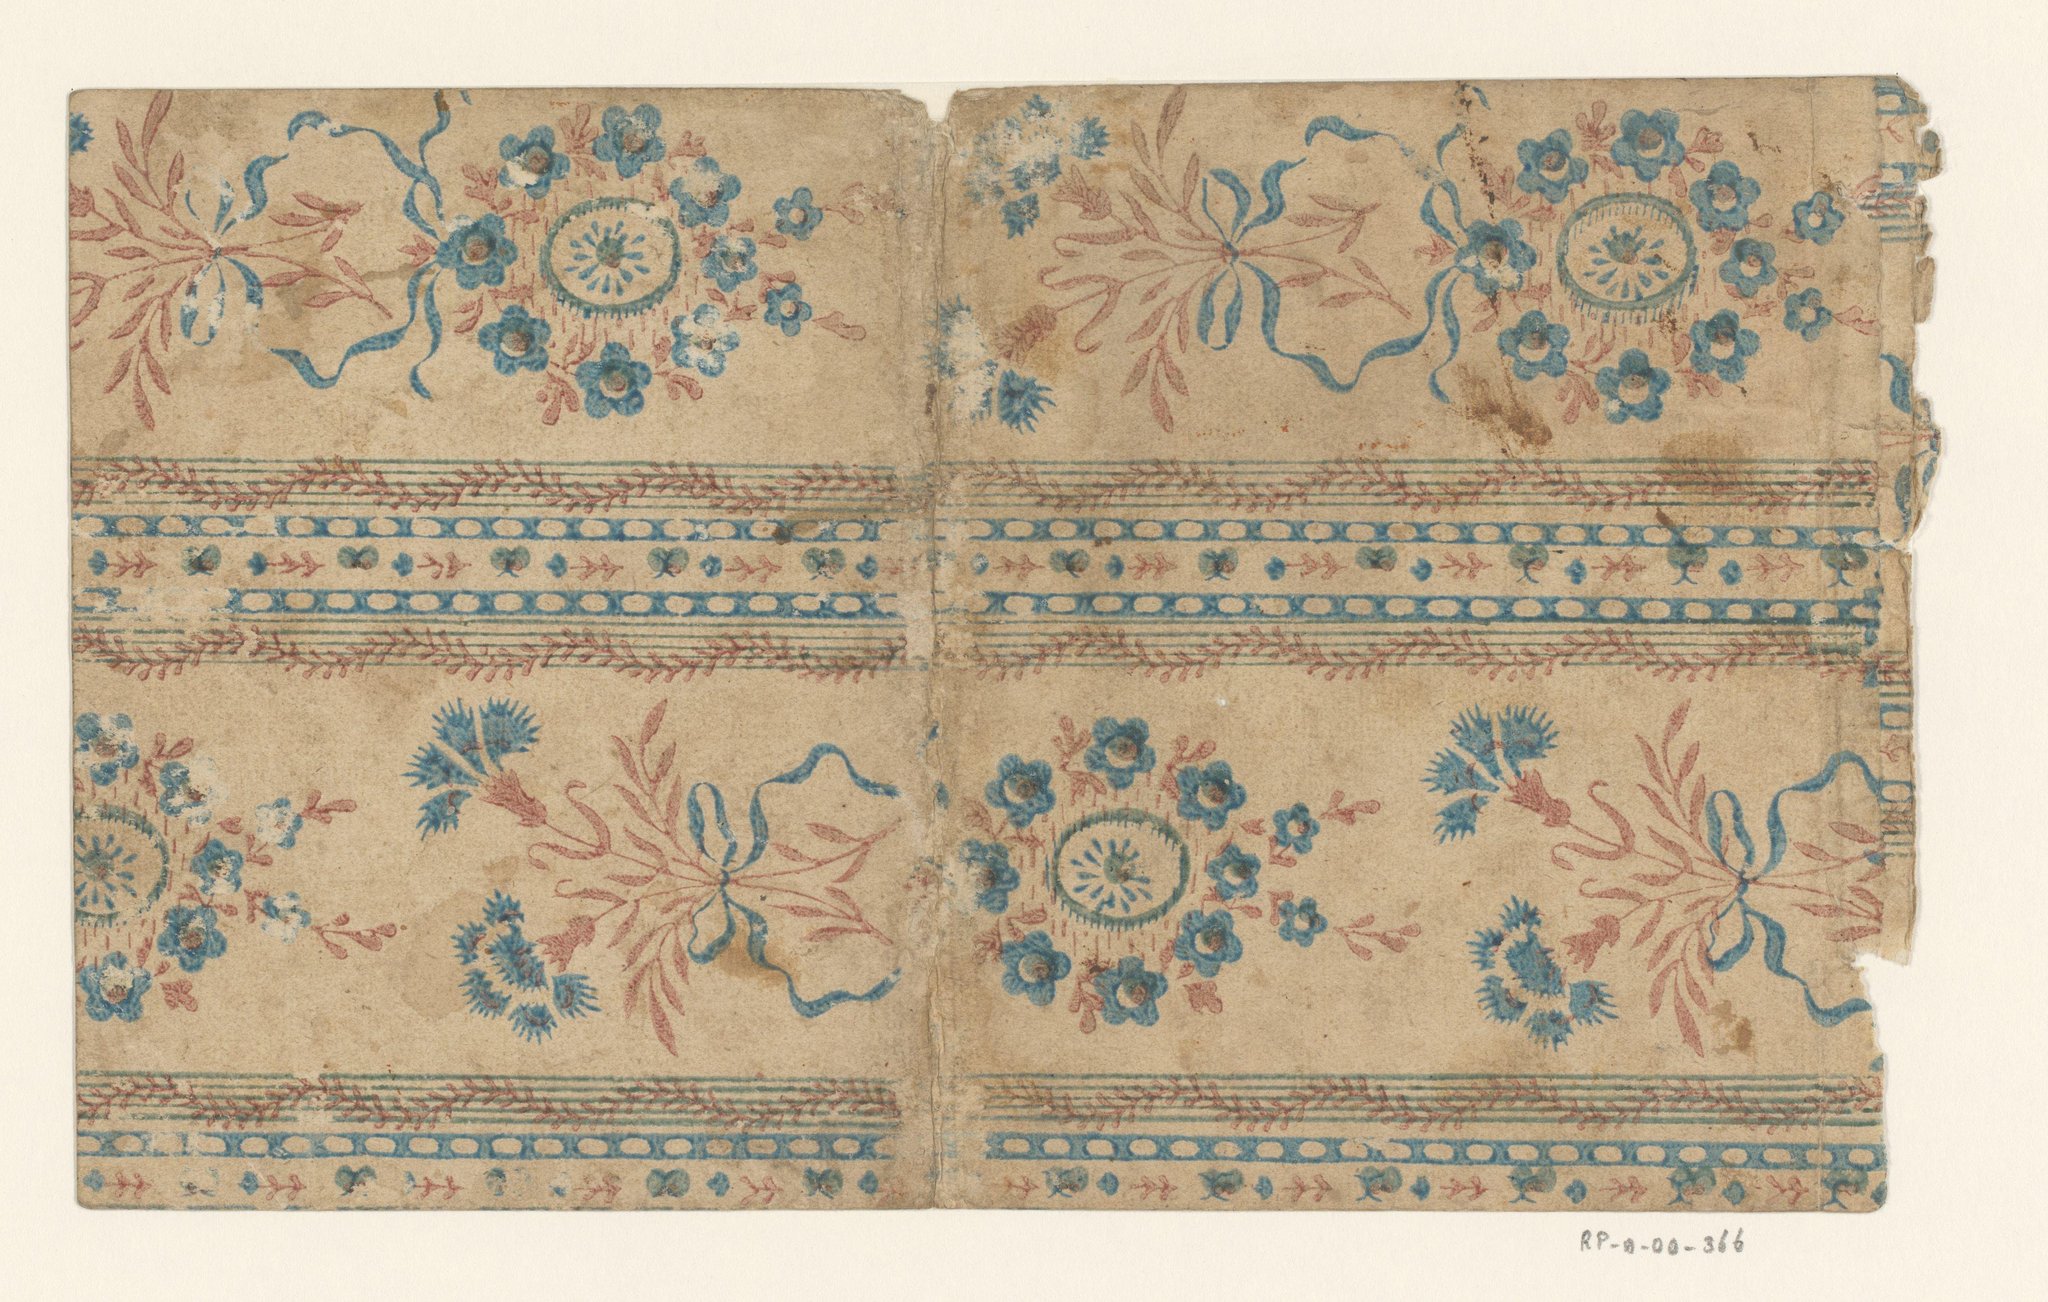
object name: wrapper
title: Blad met banenpatroon van bloemen met strikken en sierlijsten met slingerende rank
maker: Anonymous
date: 1700-1850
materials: paper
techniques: printing block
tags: ornament derived from plant forms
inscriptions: collector's mark: Lugt 2228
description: Blad met banenpatroon van bloemen met strikken tussen bloemornamenten en sierlijsten met losse bloemen, ovalen en slingerende ranken. Gebruikt als omslag.